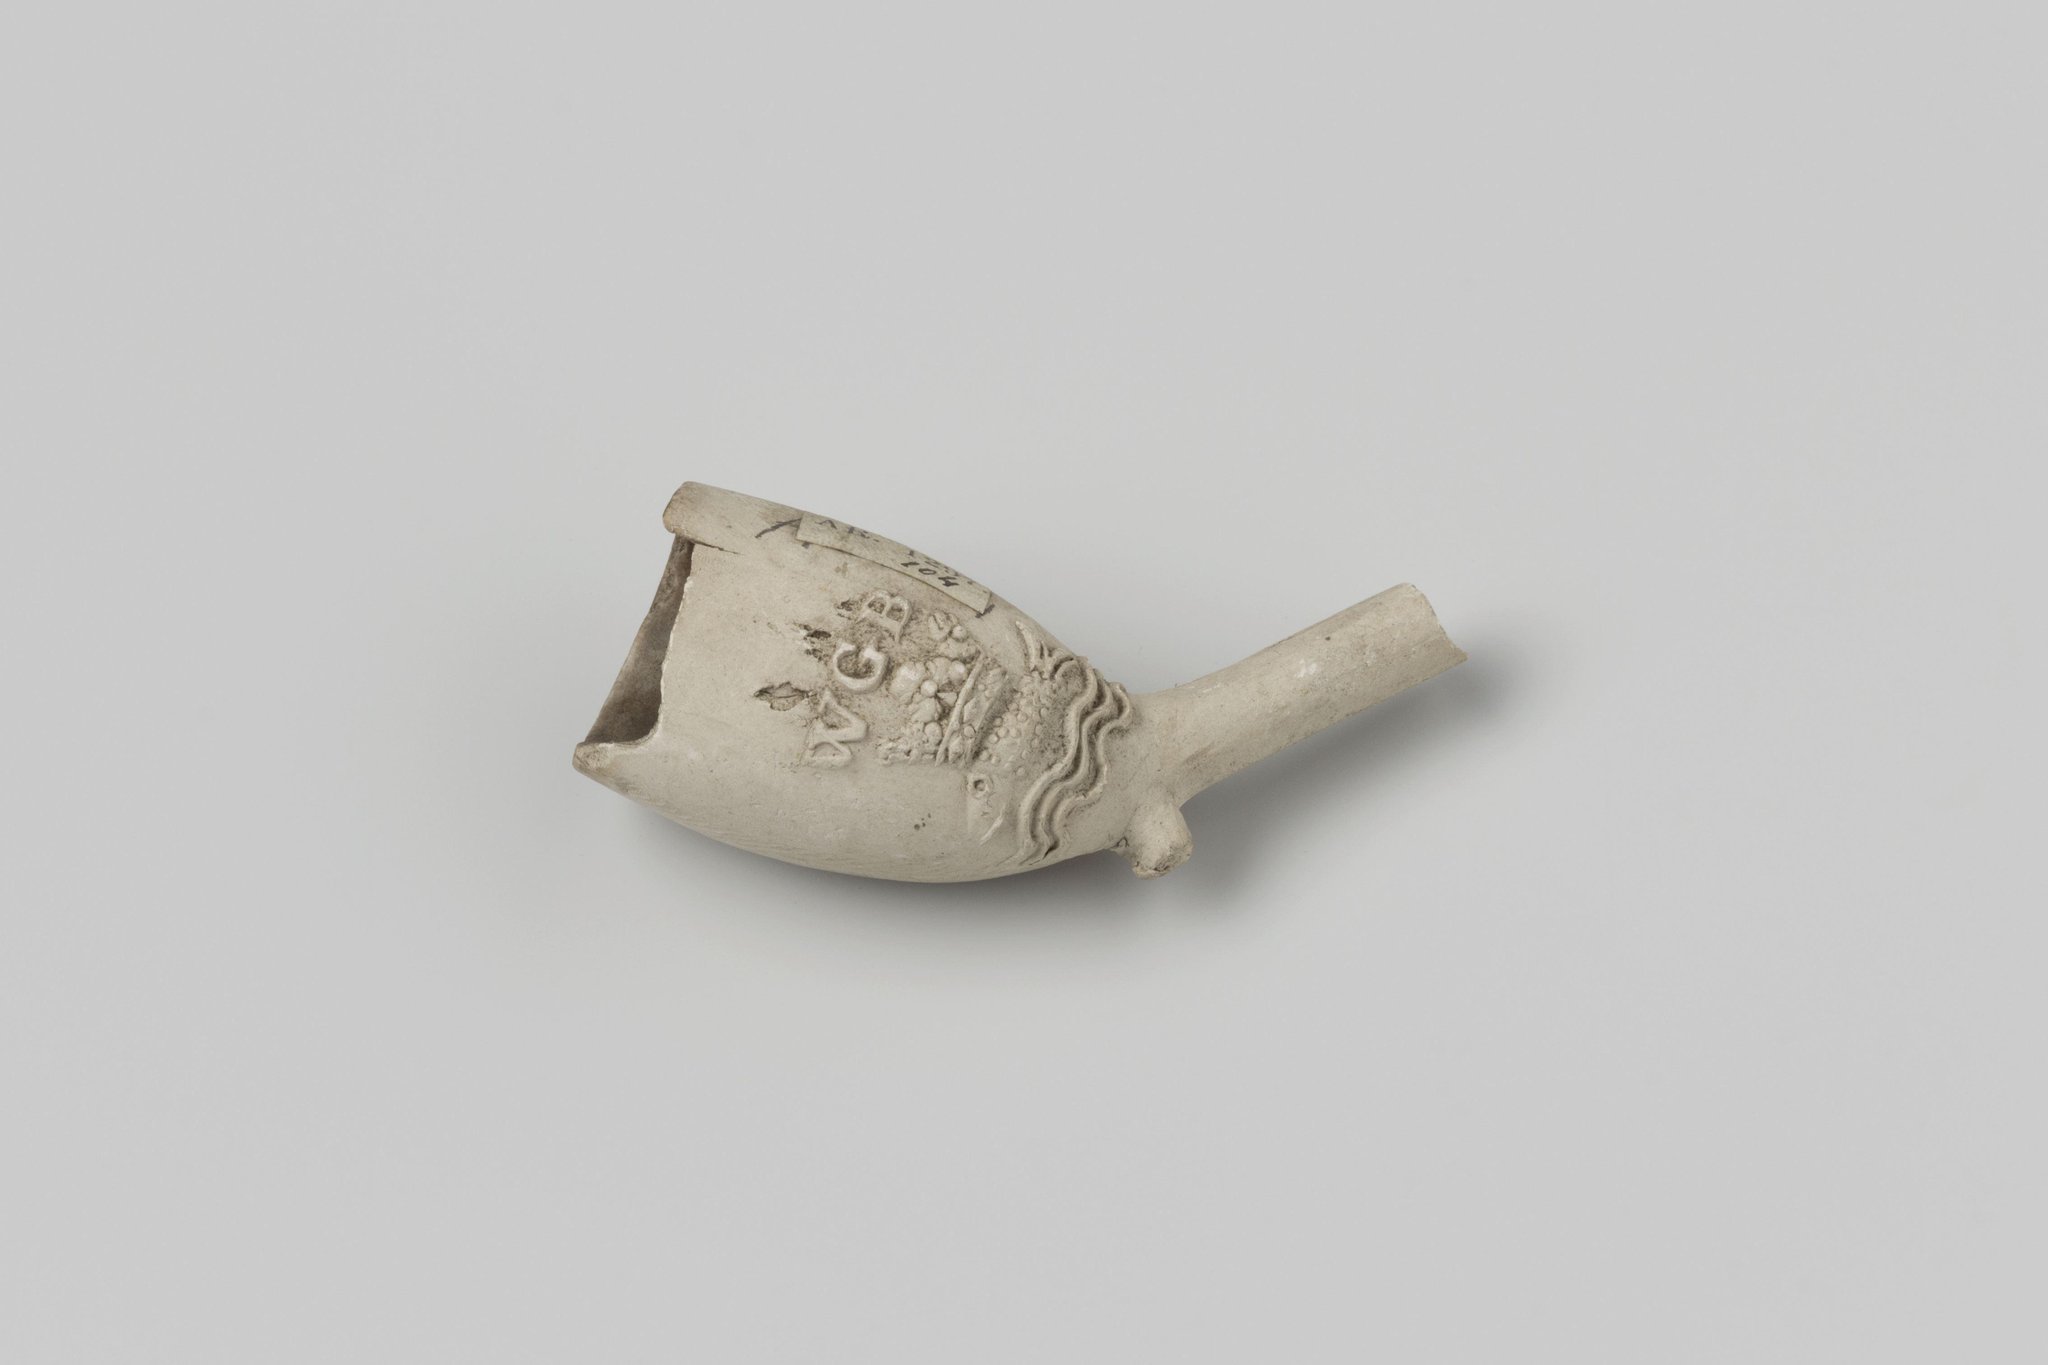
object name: fragment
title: Fragment tabakspijp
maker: wouter groenenberg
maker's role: pijpenfabrikant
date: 1750-1785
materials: clay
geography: gorinchem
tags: the hague, rotterdam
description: Fragment tabakspijp met een kroon, een vis, drie golven en de letters W G B afgebeeld. Van de opgravingen op de Hofstede Arentsburg 1827-1831 onder toezicht van Professor Reuvens.